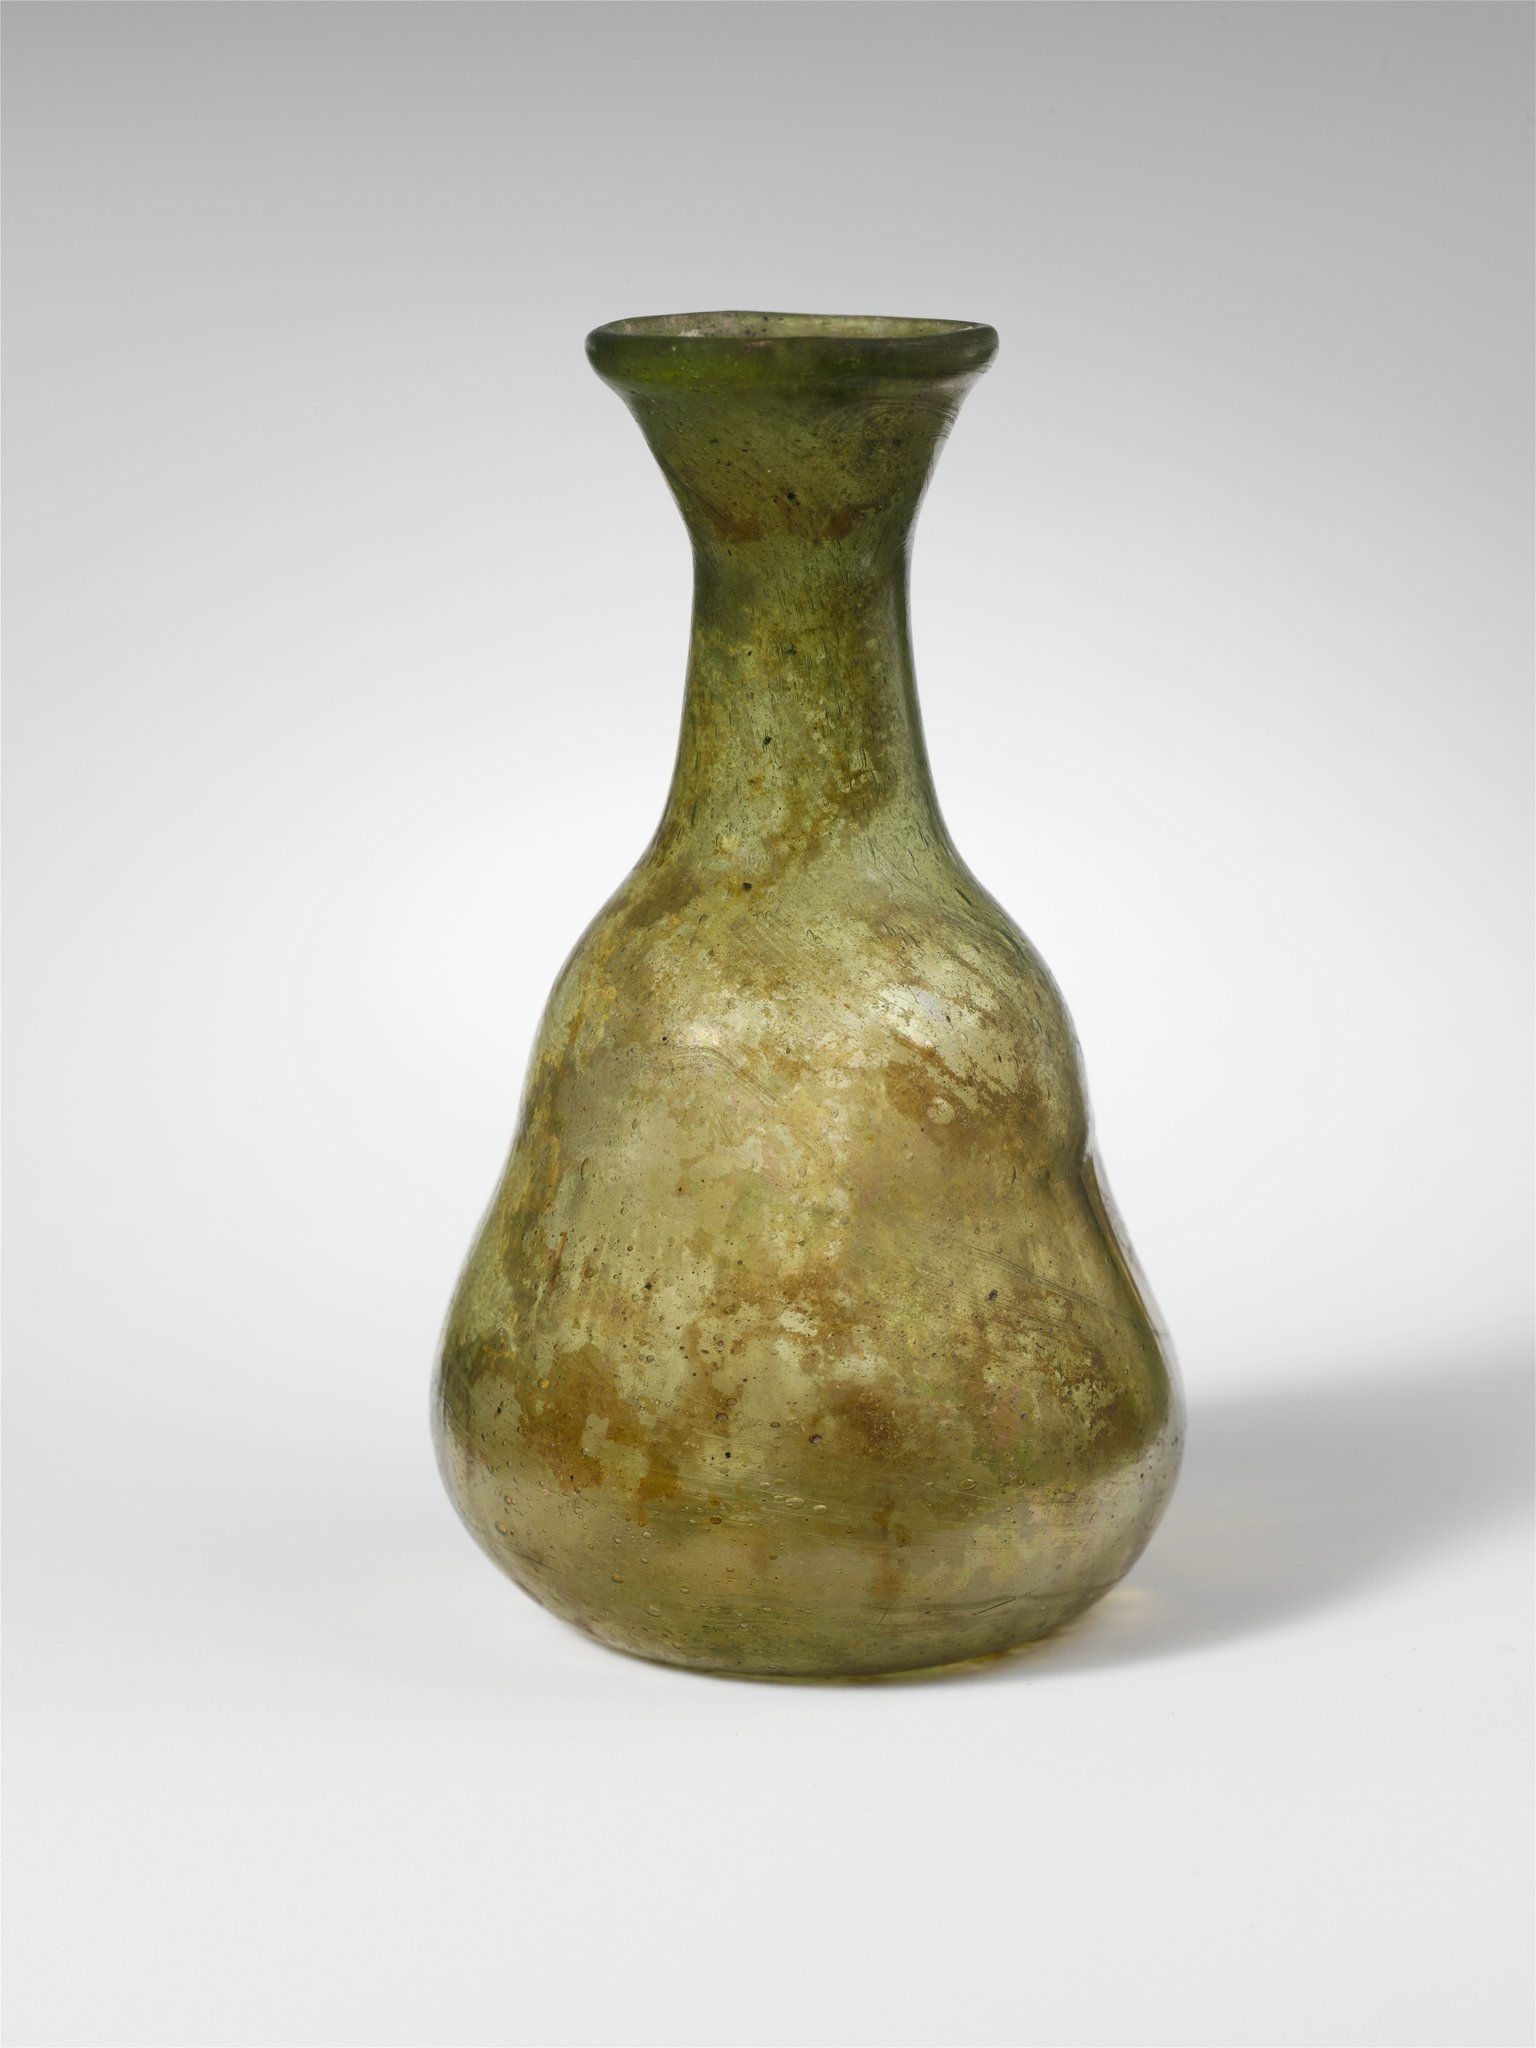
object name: bottle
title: Glass bottle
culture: roman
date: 301-500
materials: glass